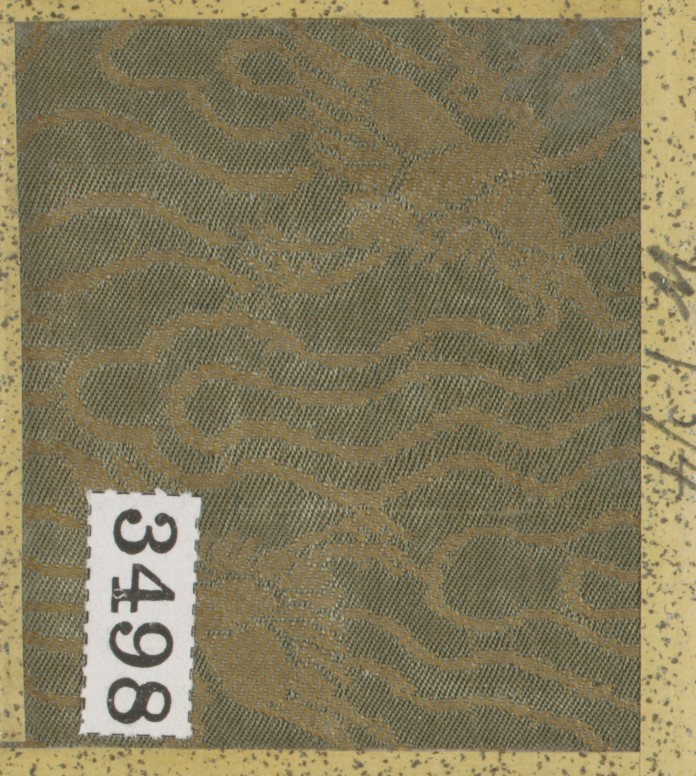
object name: sample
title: Textile Sample from Sample Book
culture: japanese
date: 1801-1900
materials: silk